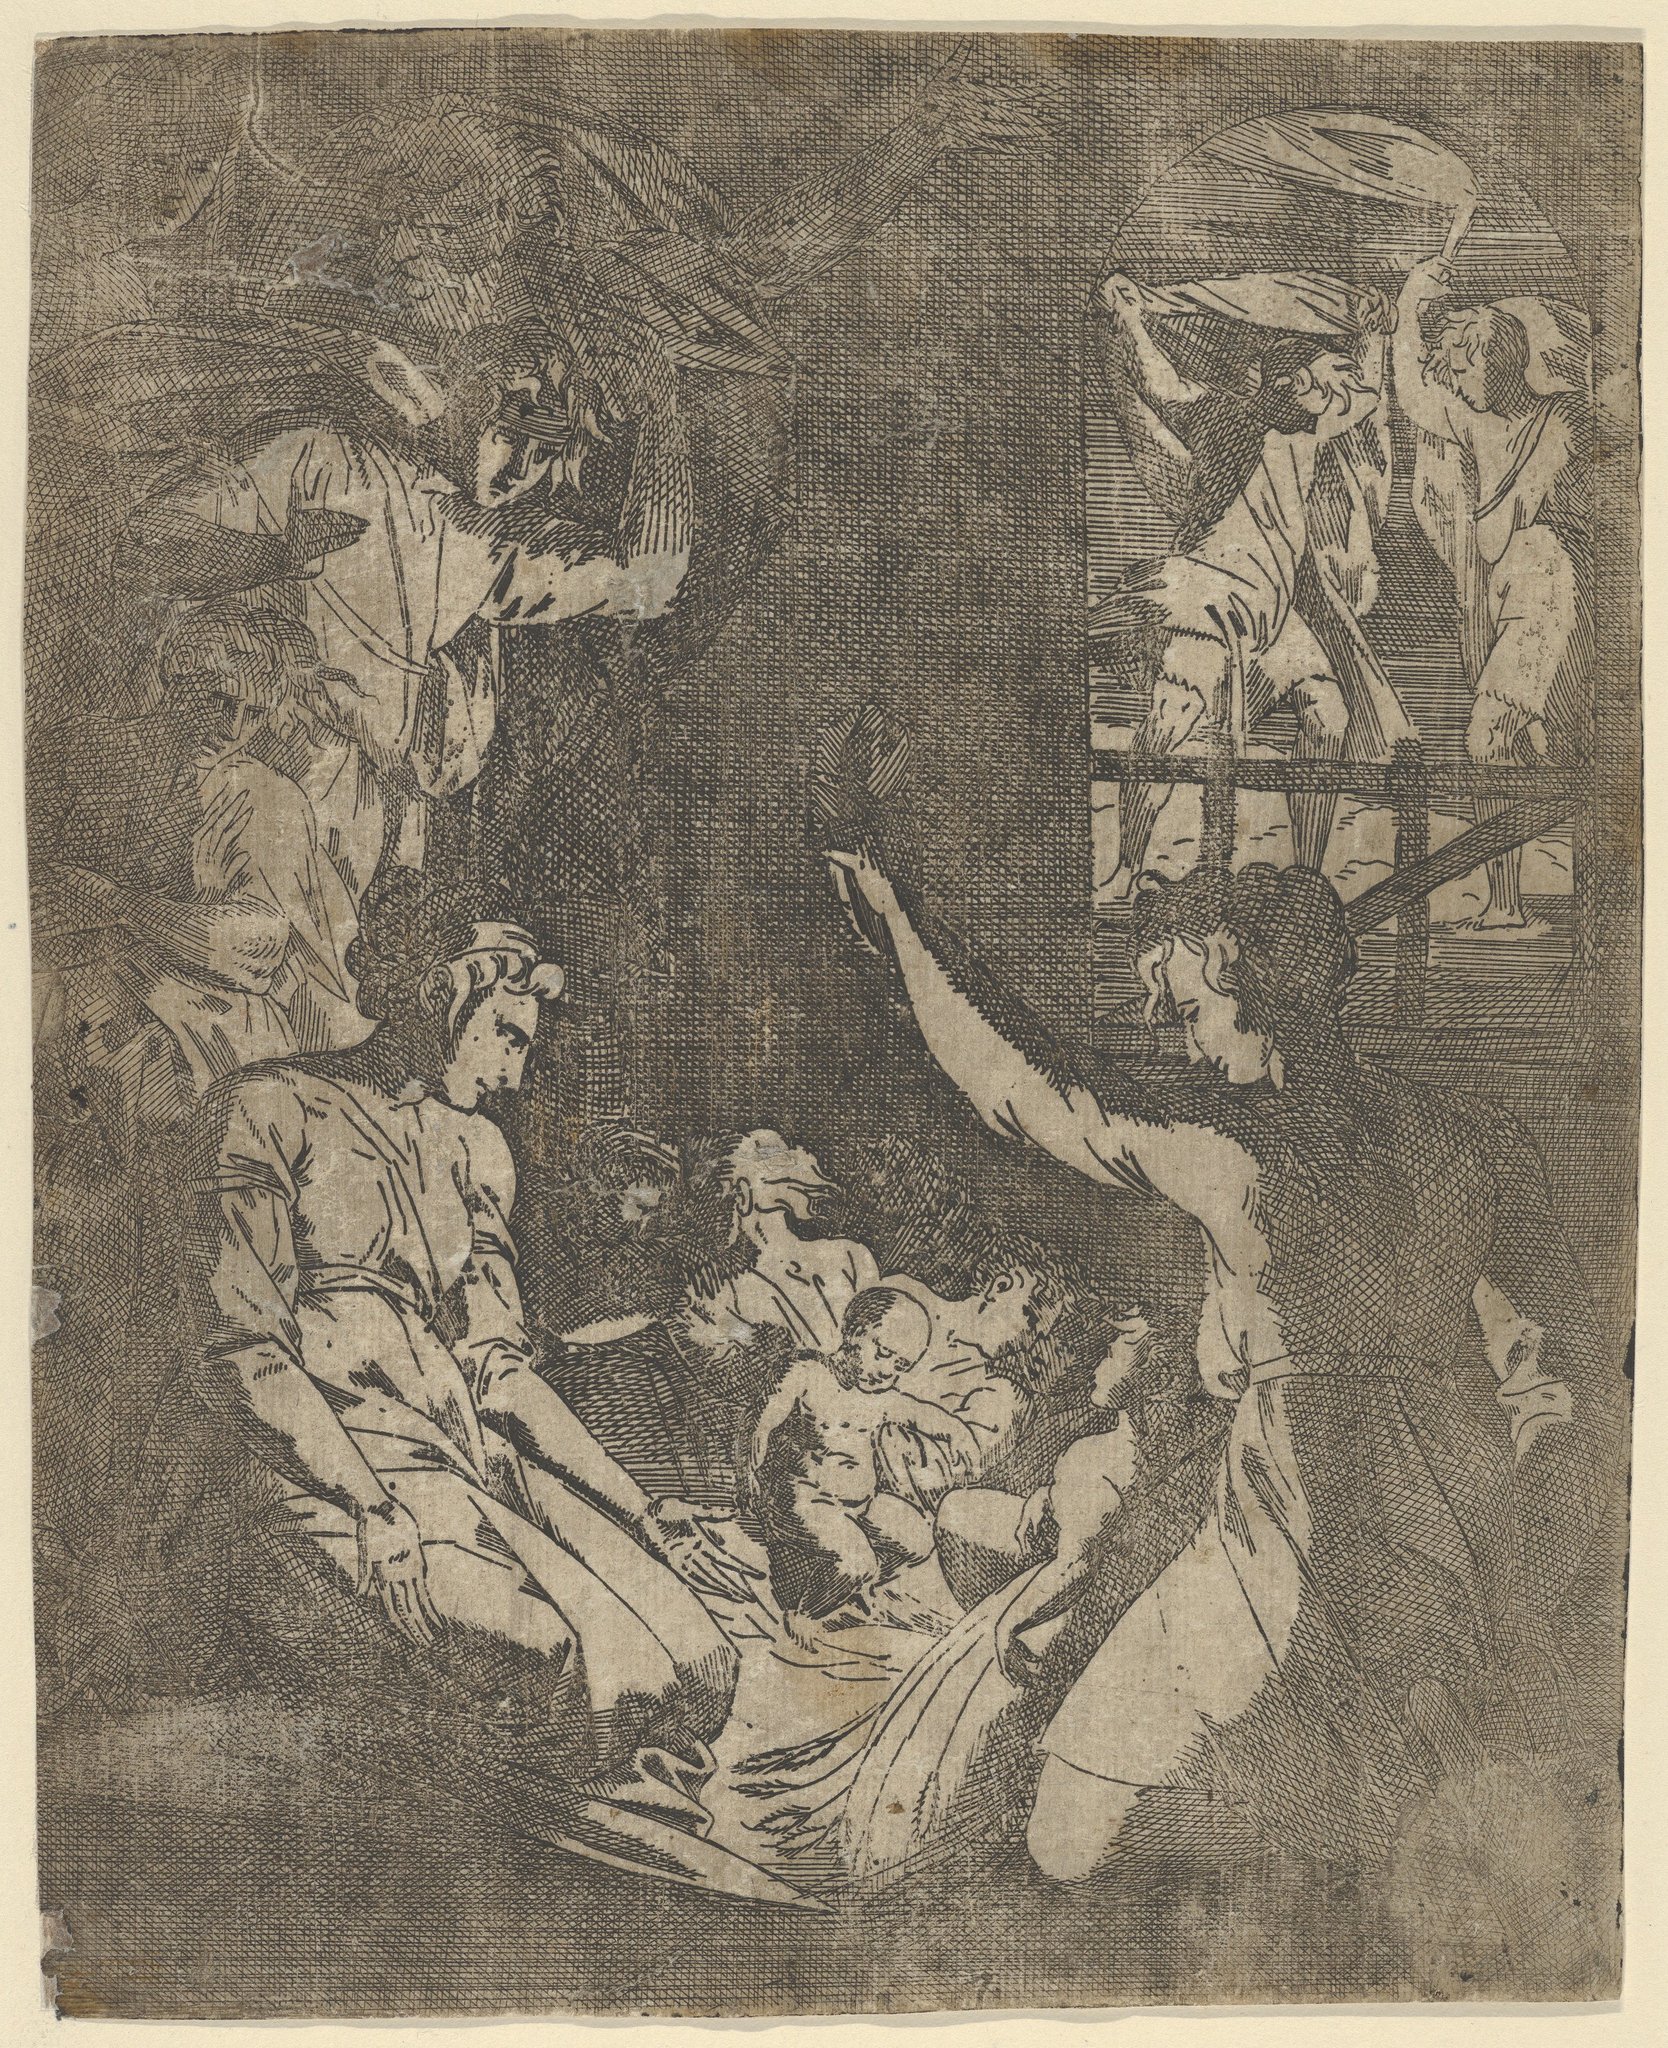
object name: print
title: The Nativity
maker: geoffroy dumoûtier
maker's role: artist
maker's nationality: french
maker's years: 1530-1578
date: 1530-1573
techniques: etching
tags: nativity